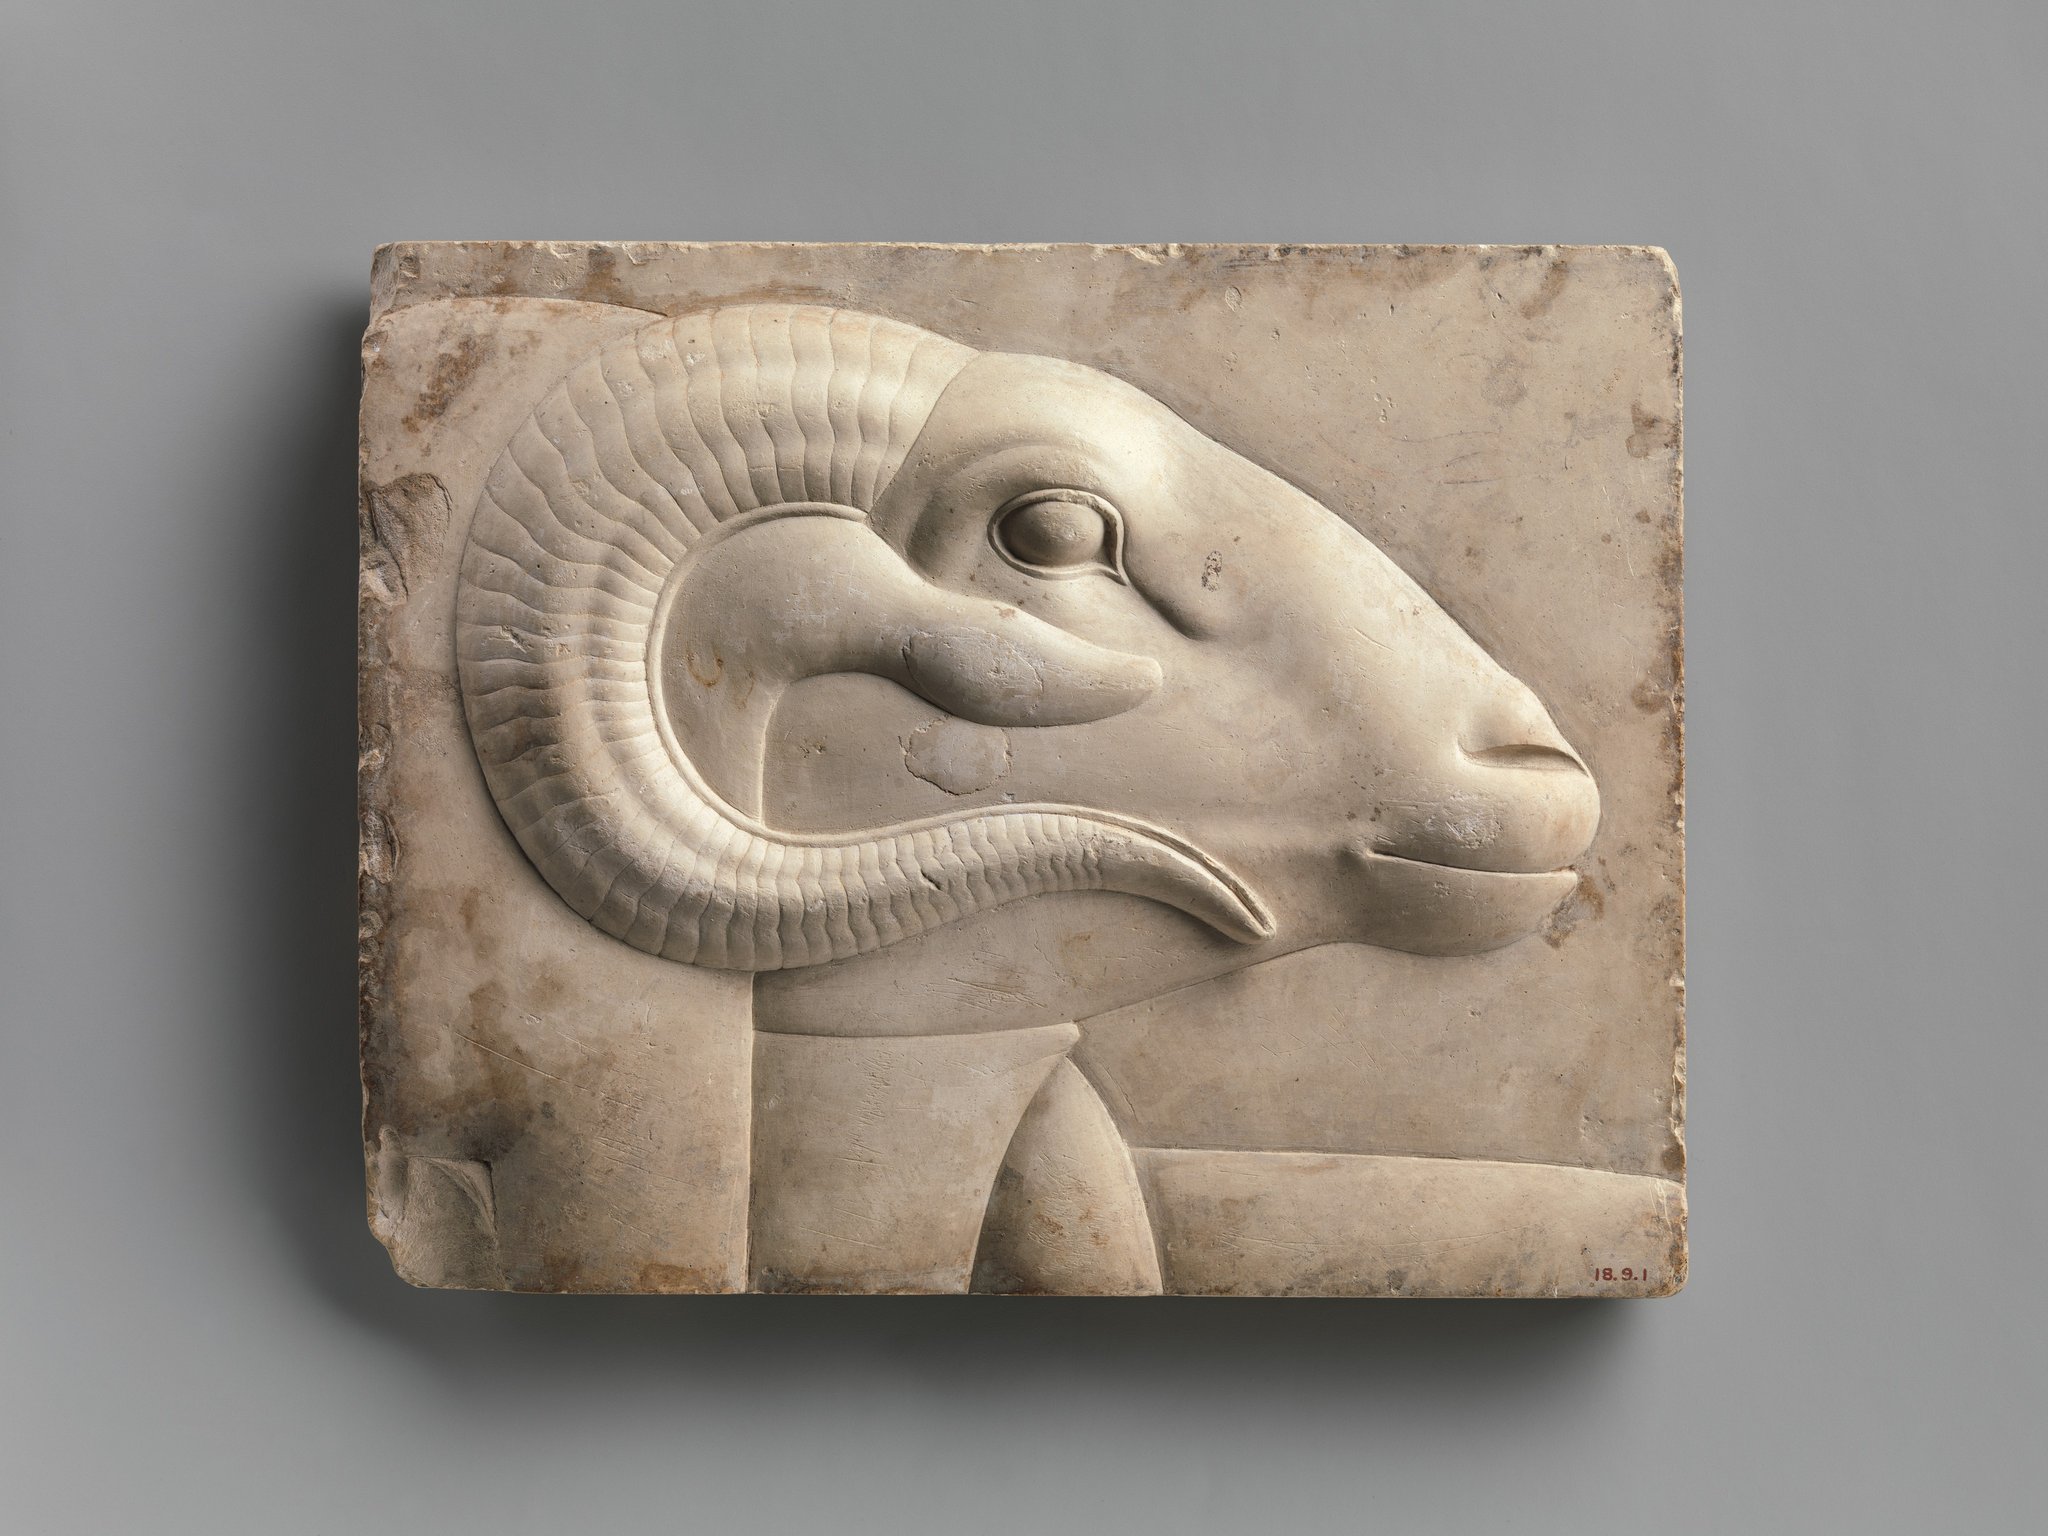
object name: sculptor's model votive, ram's head relief from god's figure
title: Relief plaque with the head of a ram deity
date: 400-30 BCE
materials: limestone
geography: egypt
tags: rams